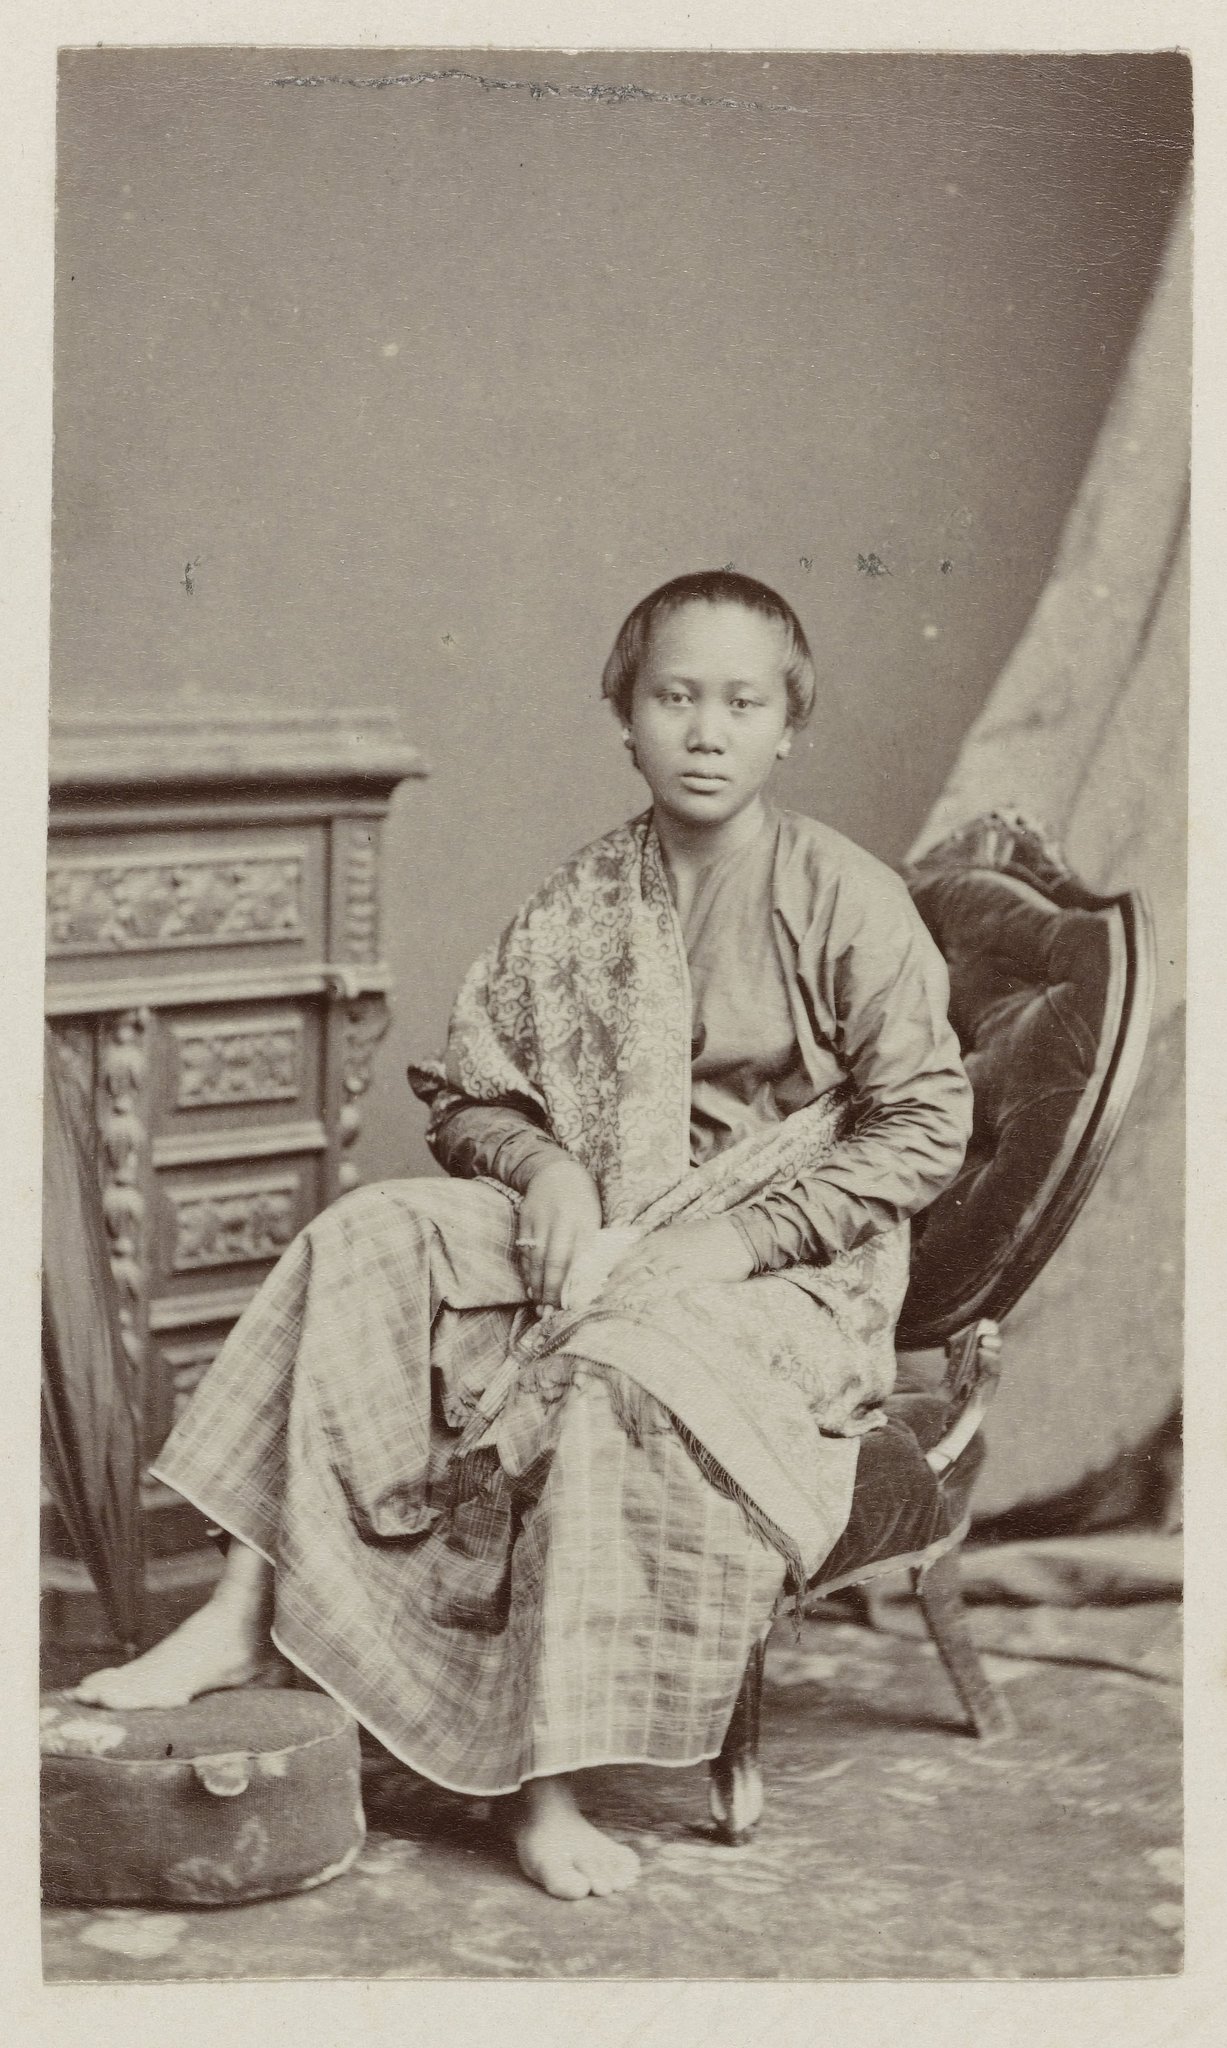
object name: photograph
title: Zittende vrouw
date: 1860-1890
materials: photographic support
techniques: albumen print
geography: celebes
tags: historical persons not known by name - bb - woman, java, batavia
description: Studioportret van een zittende Javaanse vrouw. Ingeplakte foto in het fotoalbum getiteld: Gezichten van Java.